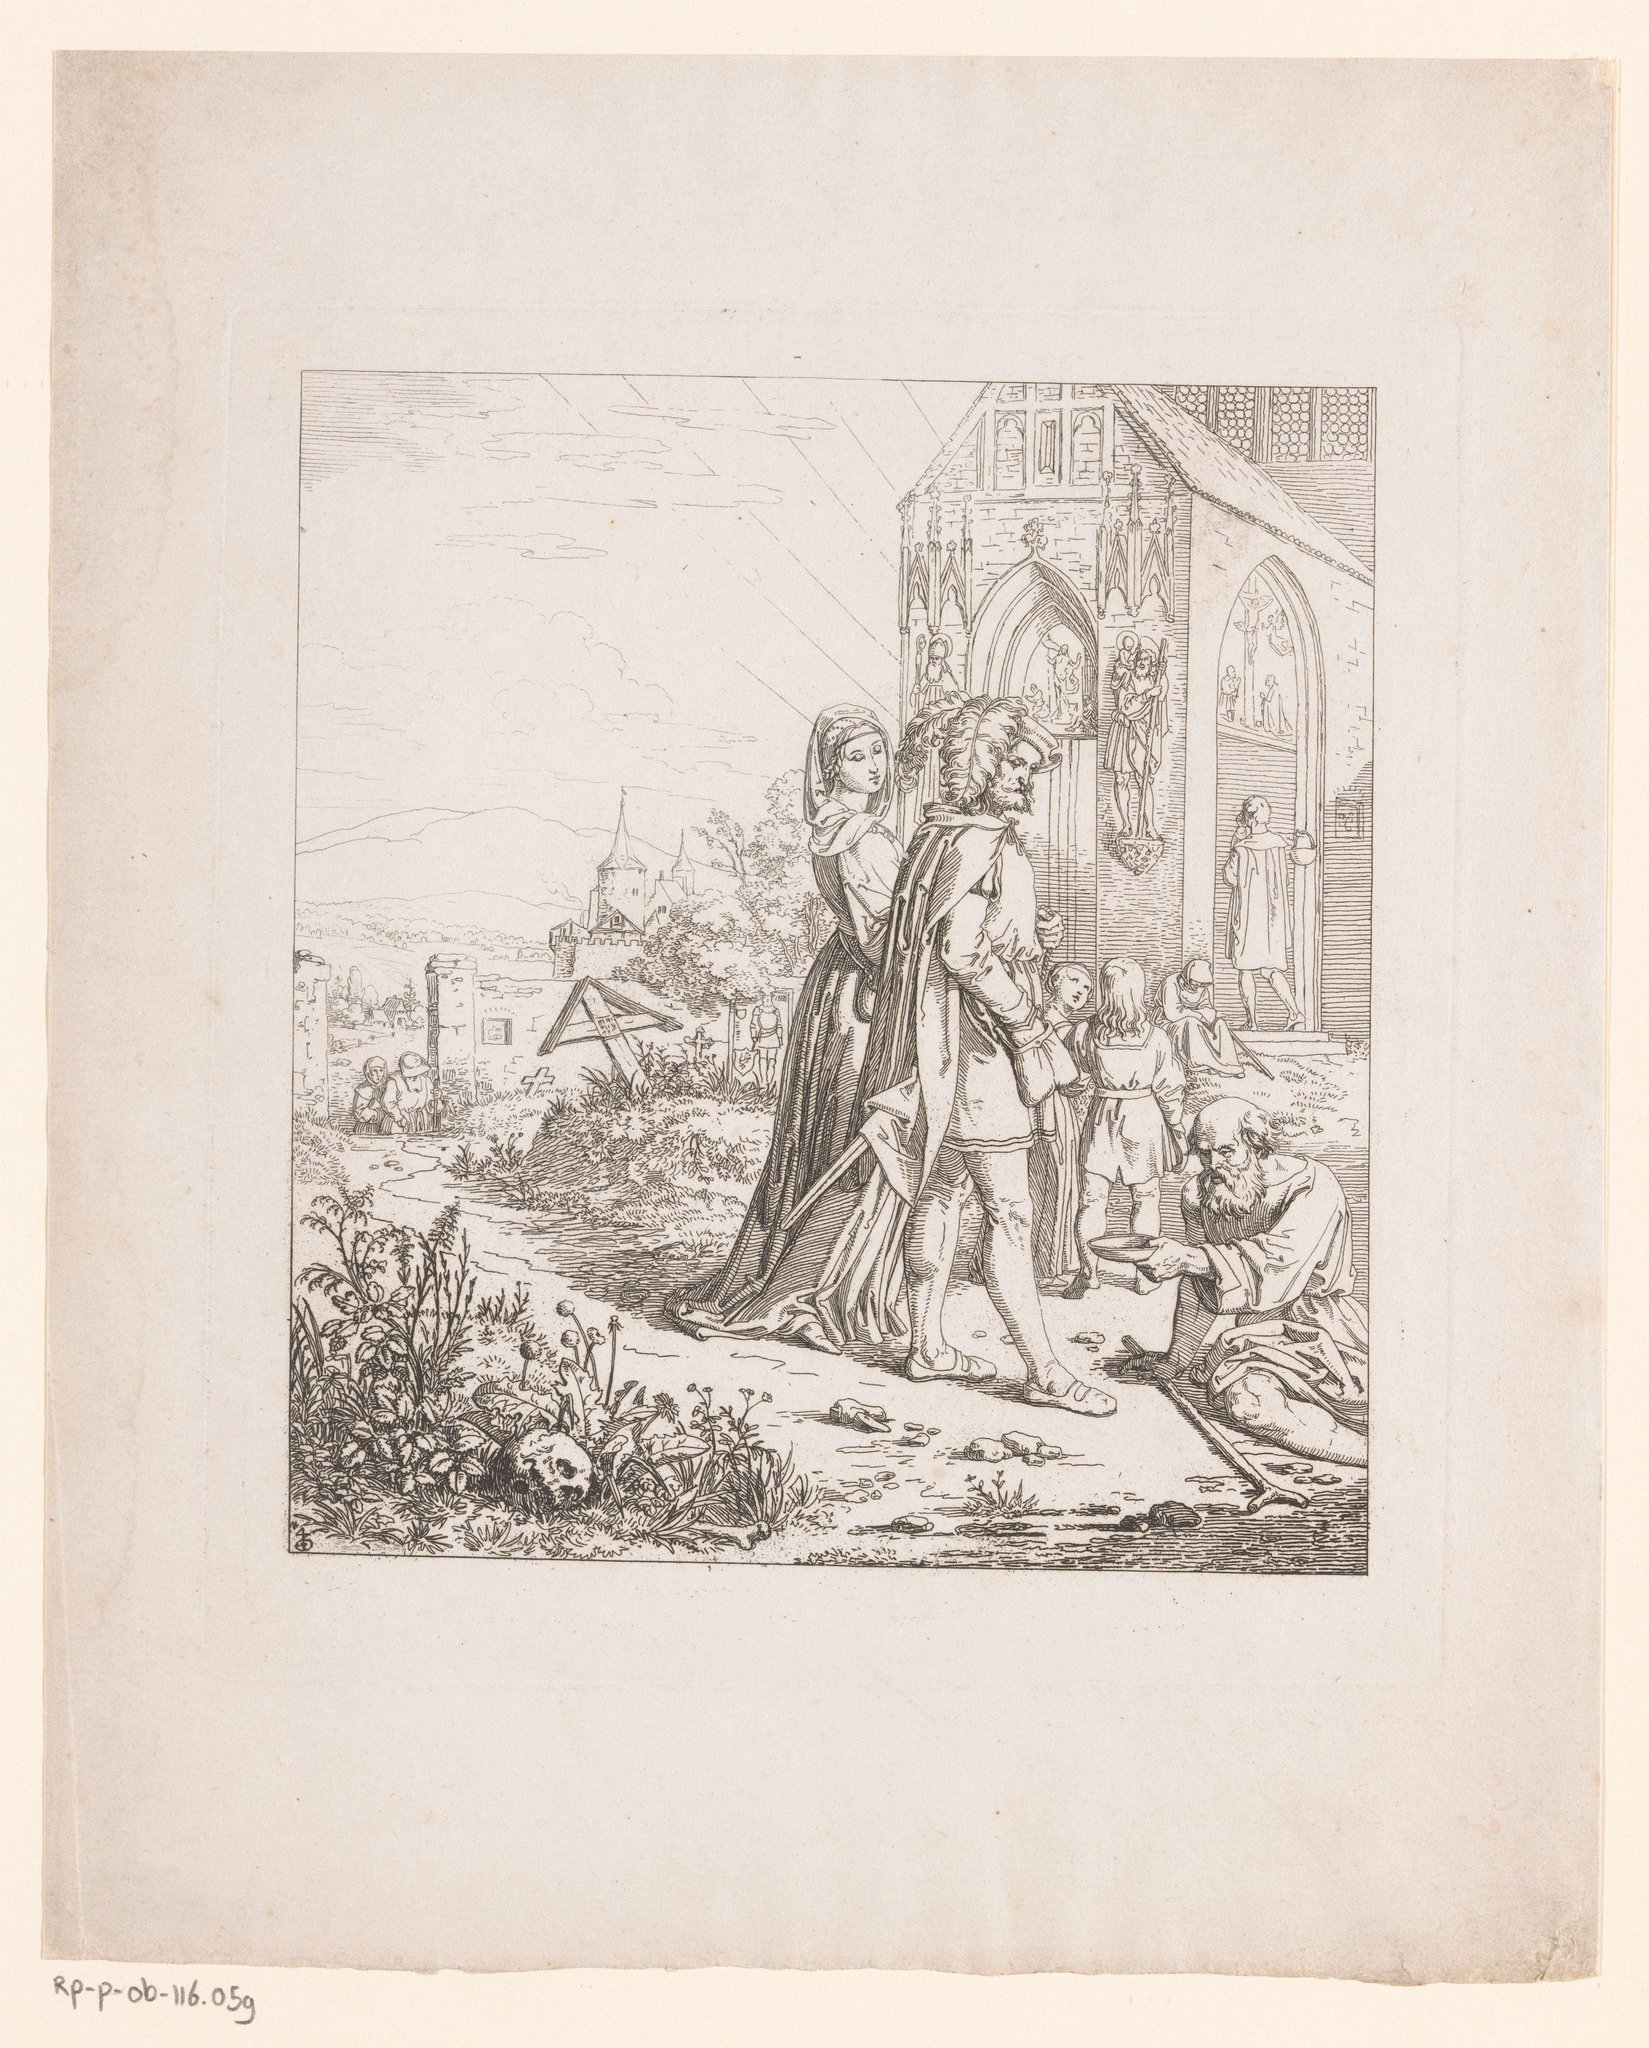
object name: print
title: Kerkgangers geven een aalmoes aan een bedelaar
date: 1840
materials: paper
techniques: etching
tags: going to church, churchyard (around church), beggar, giving alms; collection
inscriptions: collector's mark: Lugt 2228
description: Prent uit: Müller, Anton en Joseph von Führich. Das Vater Unser in neun Blättern. Praag: Peter Bohmanns Erben, 1840.